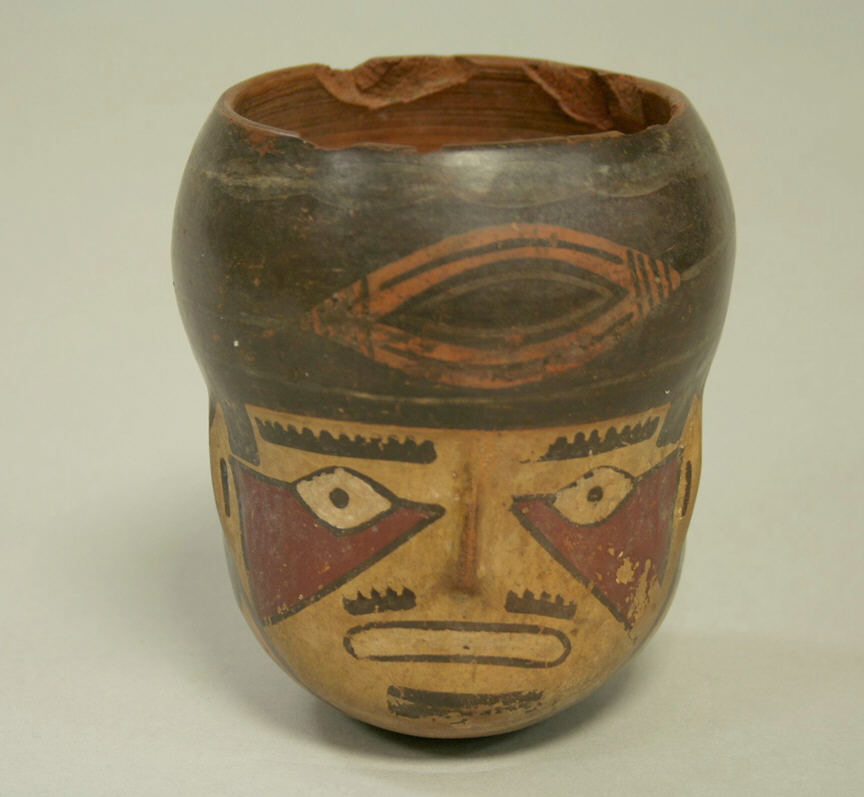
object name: vessel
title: Trophy Head Vessel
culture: nasca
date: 1-400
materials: ceramic, pigment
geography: peru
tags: heads,men